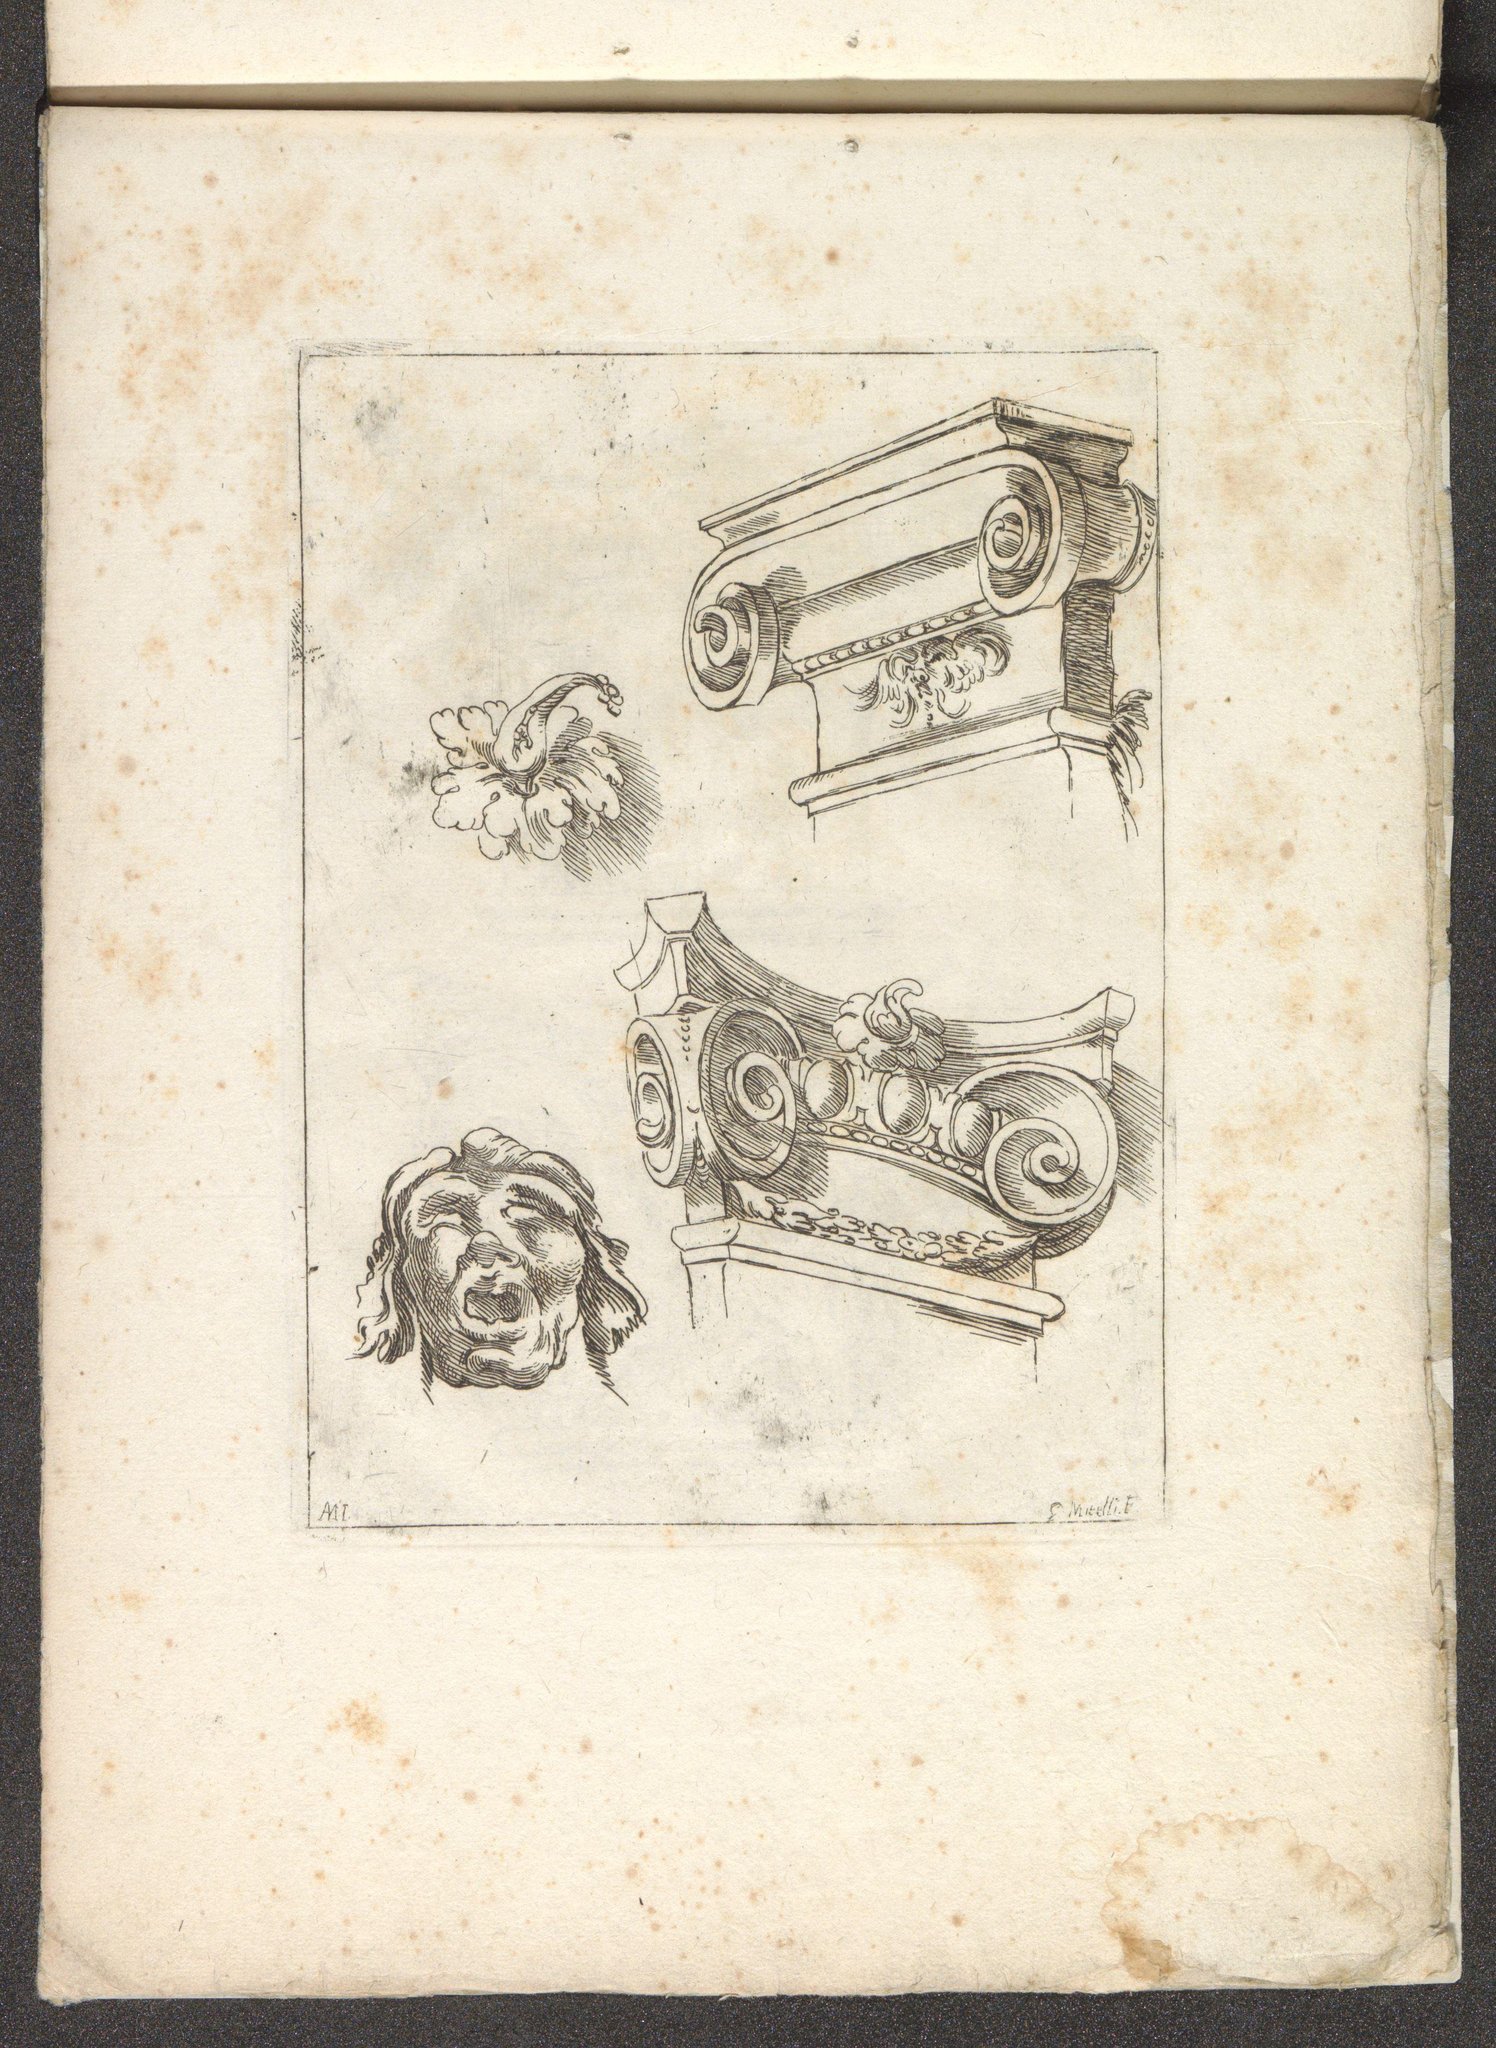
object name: album leaf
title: Ornamenten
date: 1644-1718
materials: paper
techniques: etching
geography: italy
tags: ornaments ~ art, capital (~ column, pillar), flowers ~ ornament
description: Twee kapitelen, een bloemornament en een ornamentkop. De prent maakt deel uit van een album.